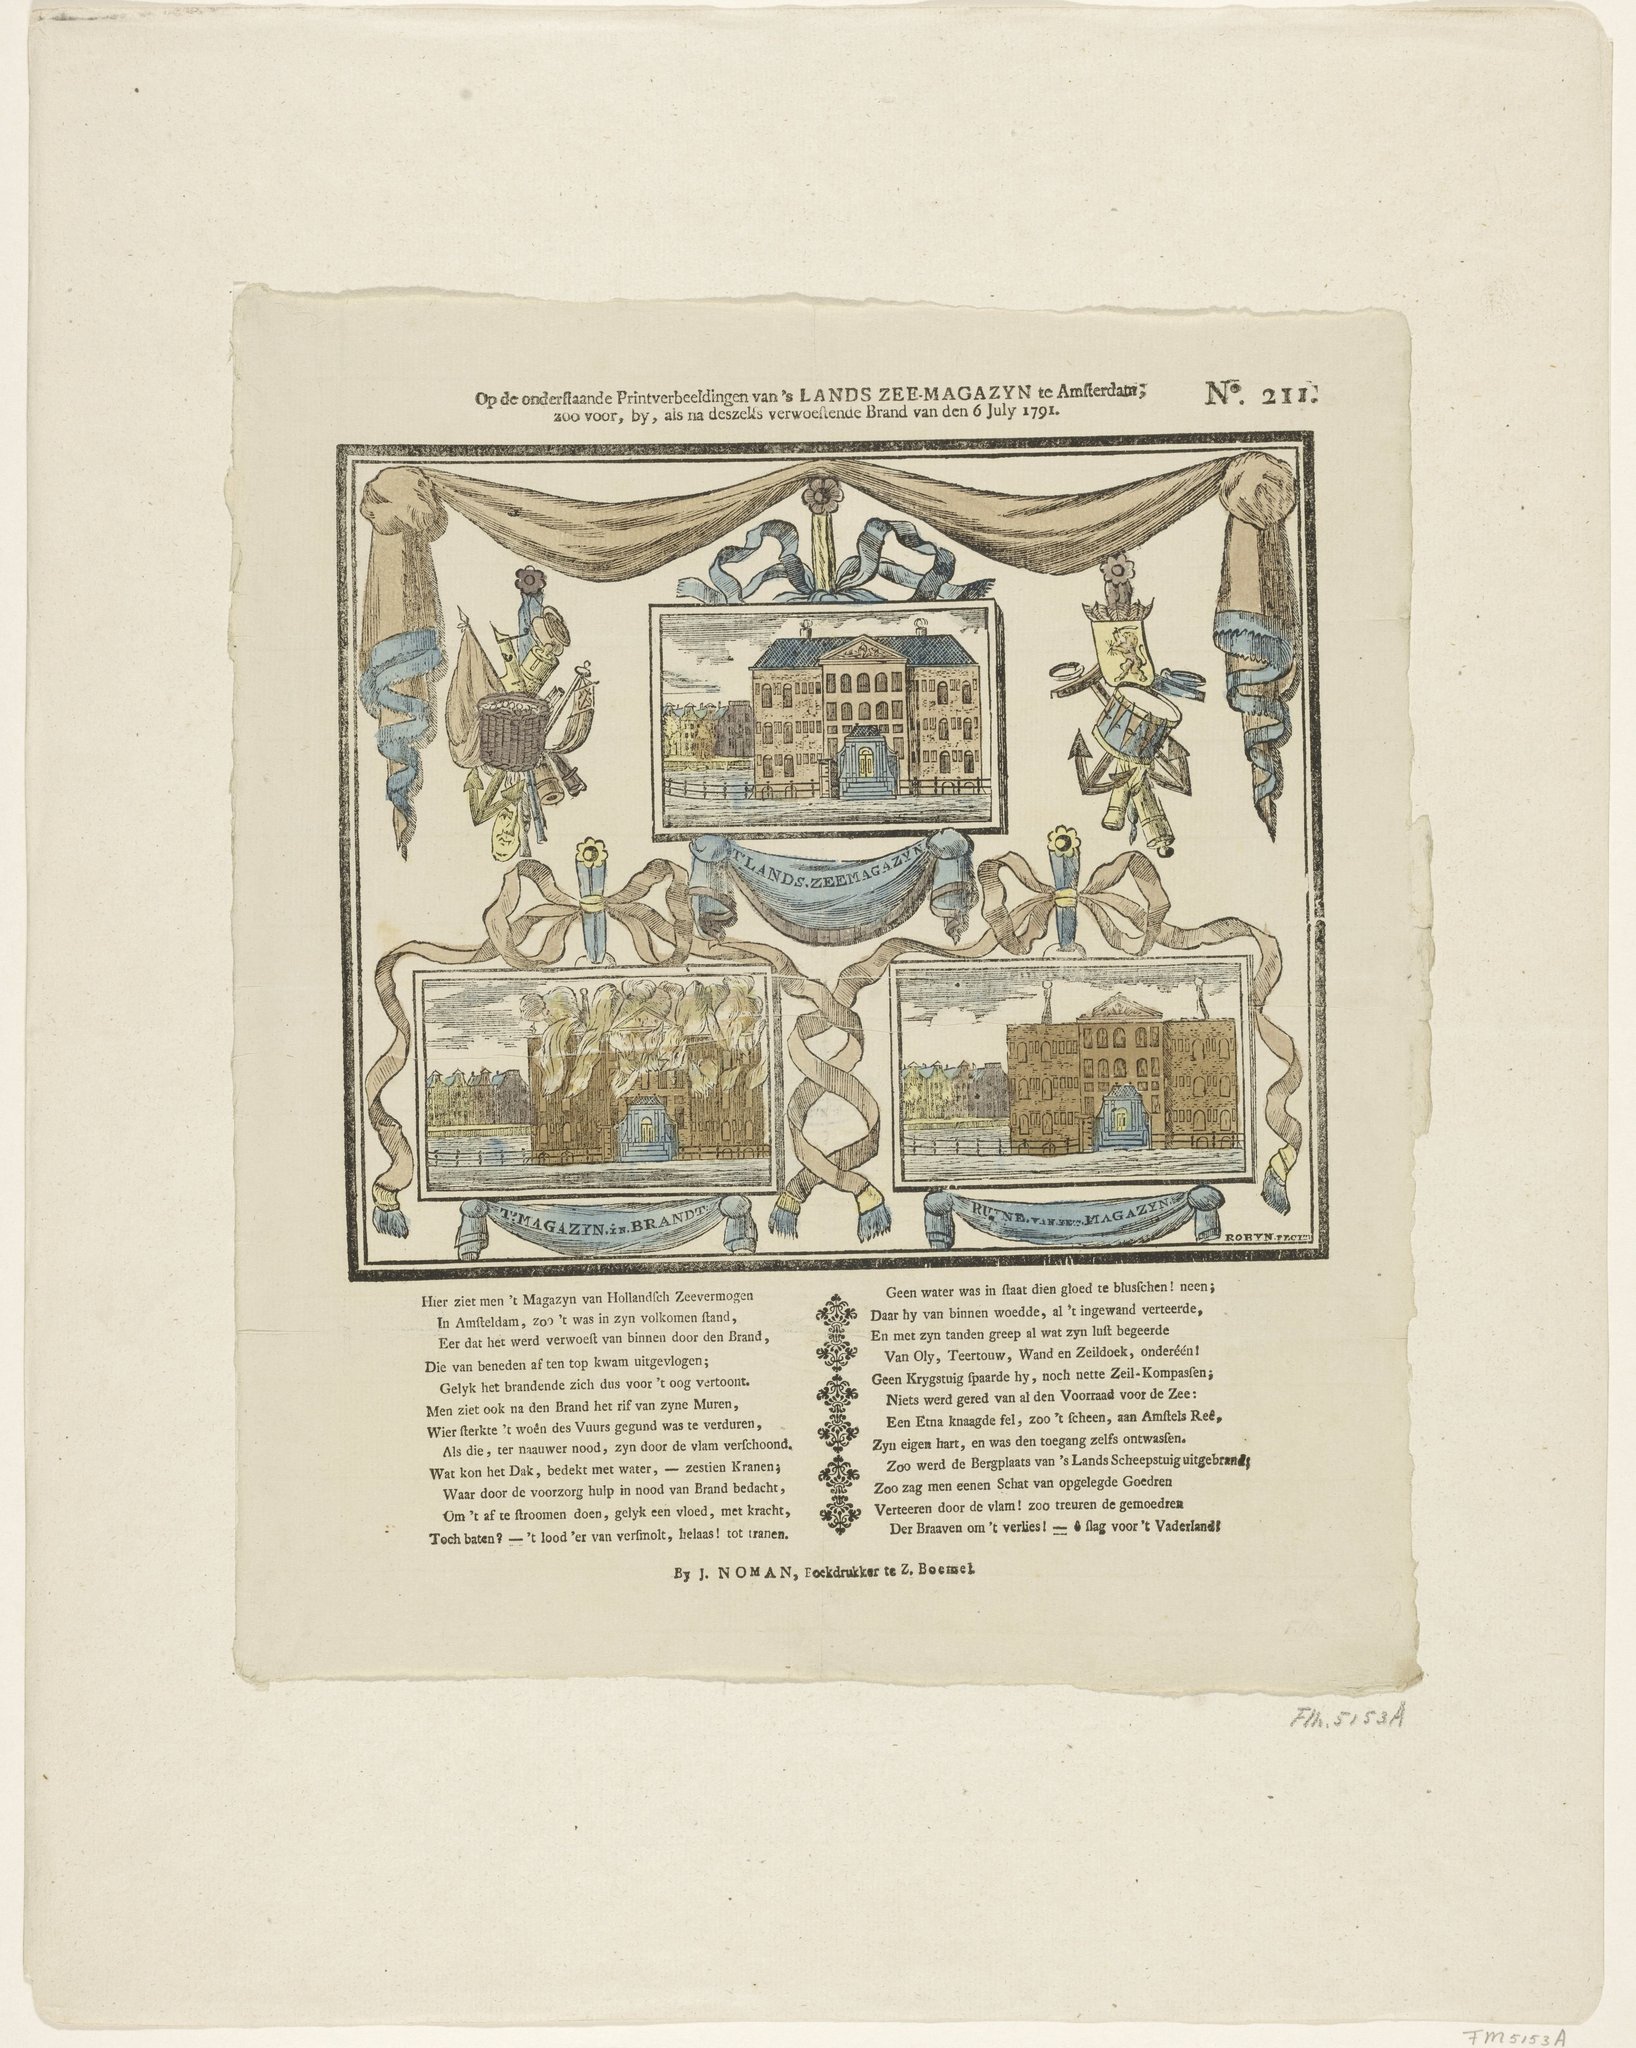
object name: print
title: Brand in het Zeemagazijn te Amsterdam, 1791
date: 1791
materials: paper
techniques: hand coloring, letterpress printing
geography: northern netherlands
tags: on fire, ablaze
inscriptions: collector's mark: Lugt 2228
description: Blad met drie voorstellingen van de grote brand in 's Lands Zeemagazijn te Amsterdam op 6 juli 1791. De afbeeldingen hangen aan strikken, met wapentrofeeën. Met een vers in twee kolommen. Genummerd rechtsboven: No. 211.